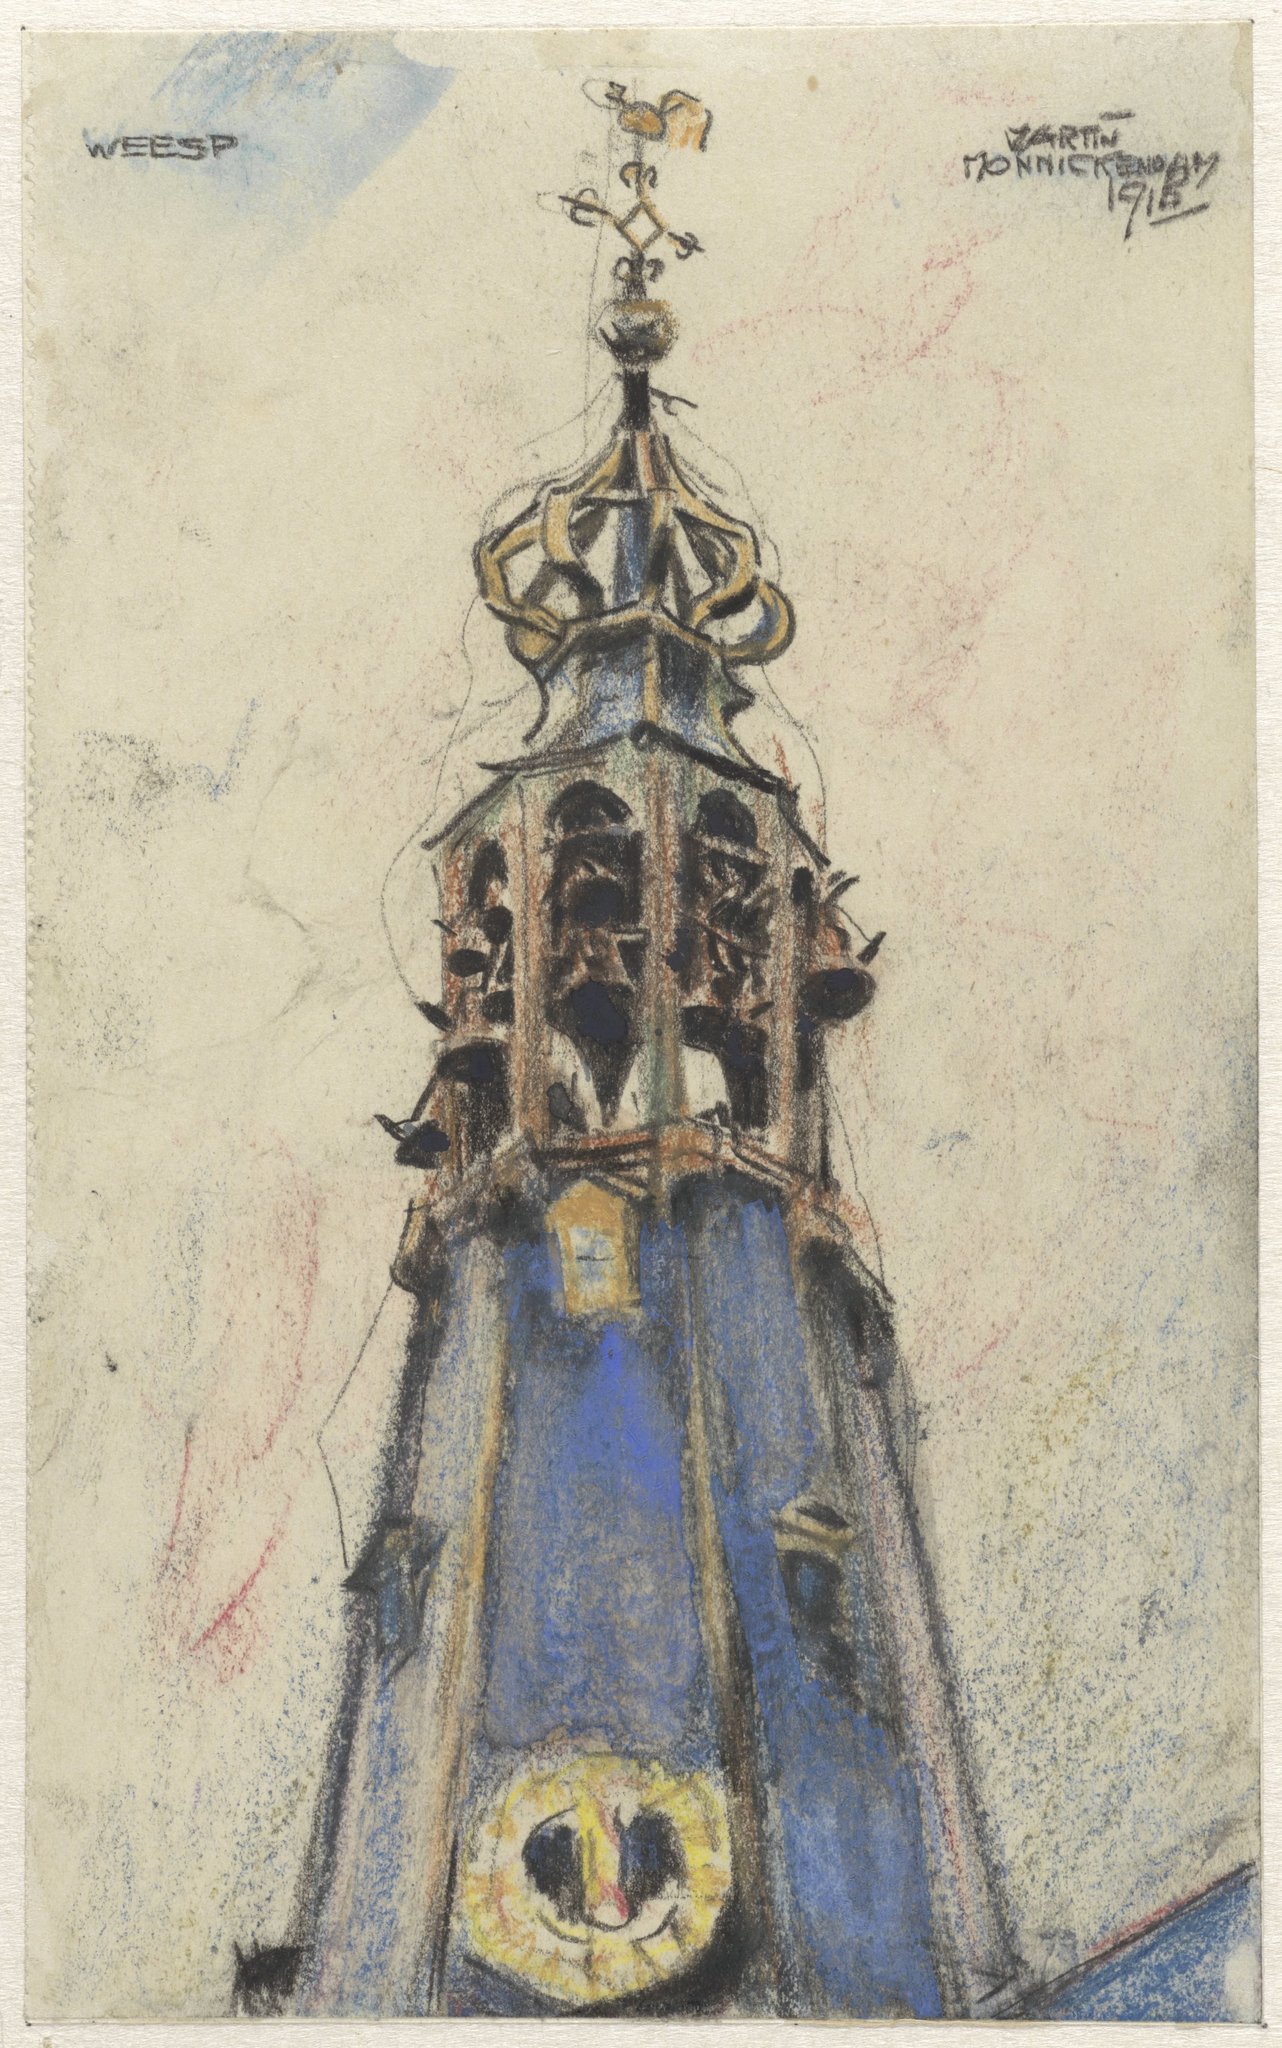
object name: drawing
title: Kerktoren te Weesp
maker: martin monnickendam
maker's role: draughtsman, painter, print maker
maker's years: 1874-1943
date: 1915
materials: chalk, paper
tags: church (exterior)